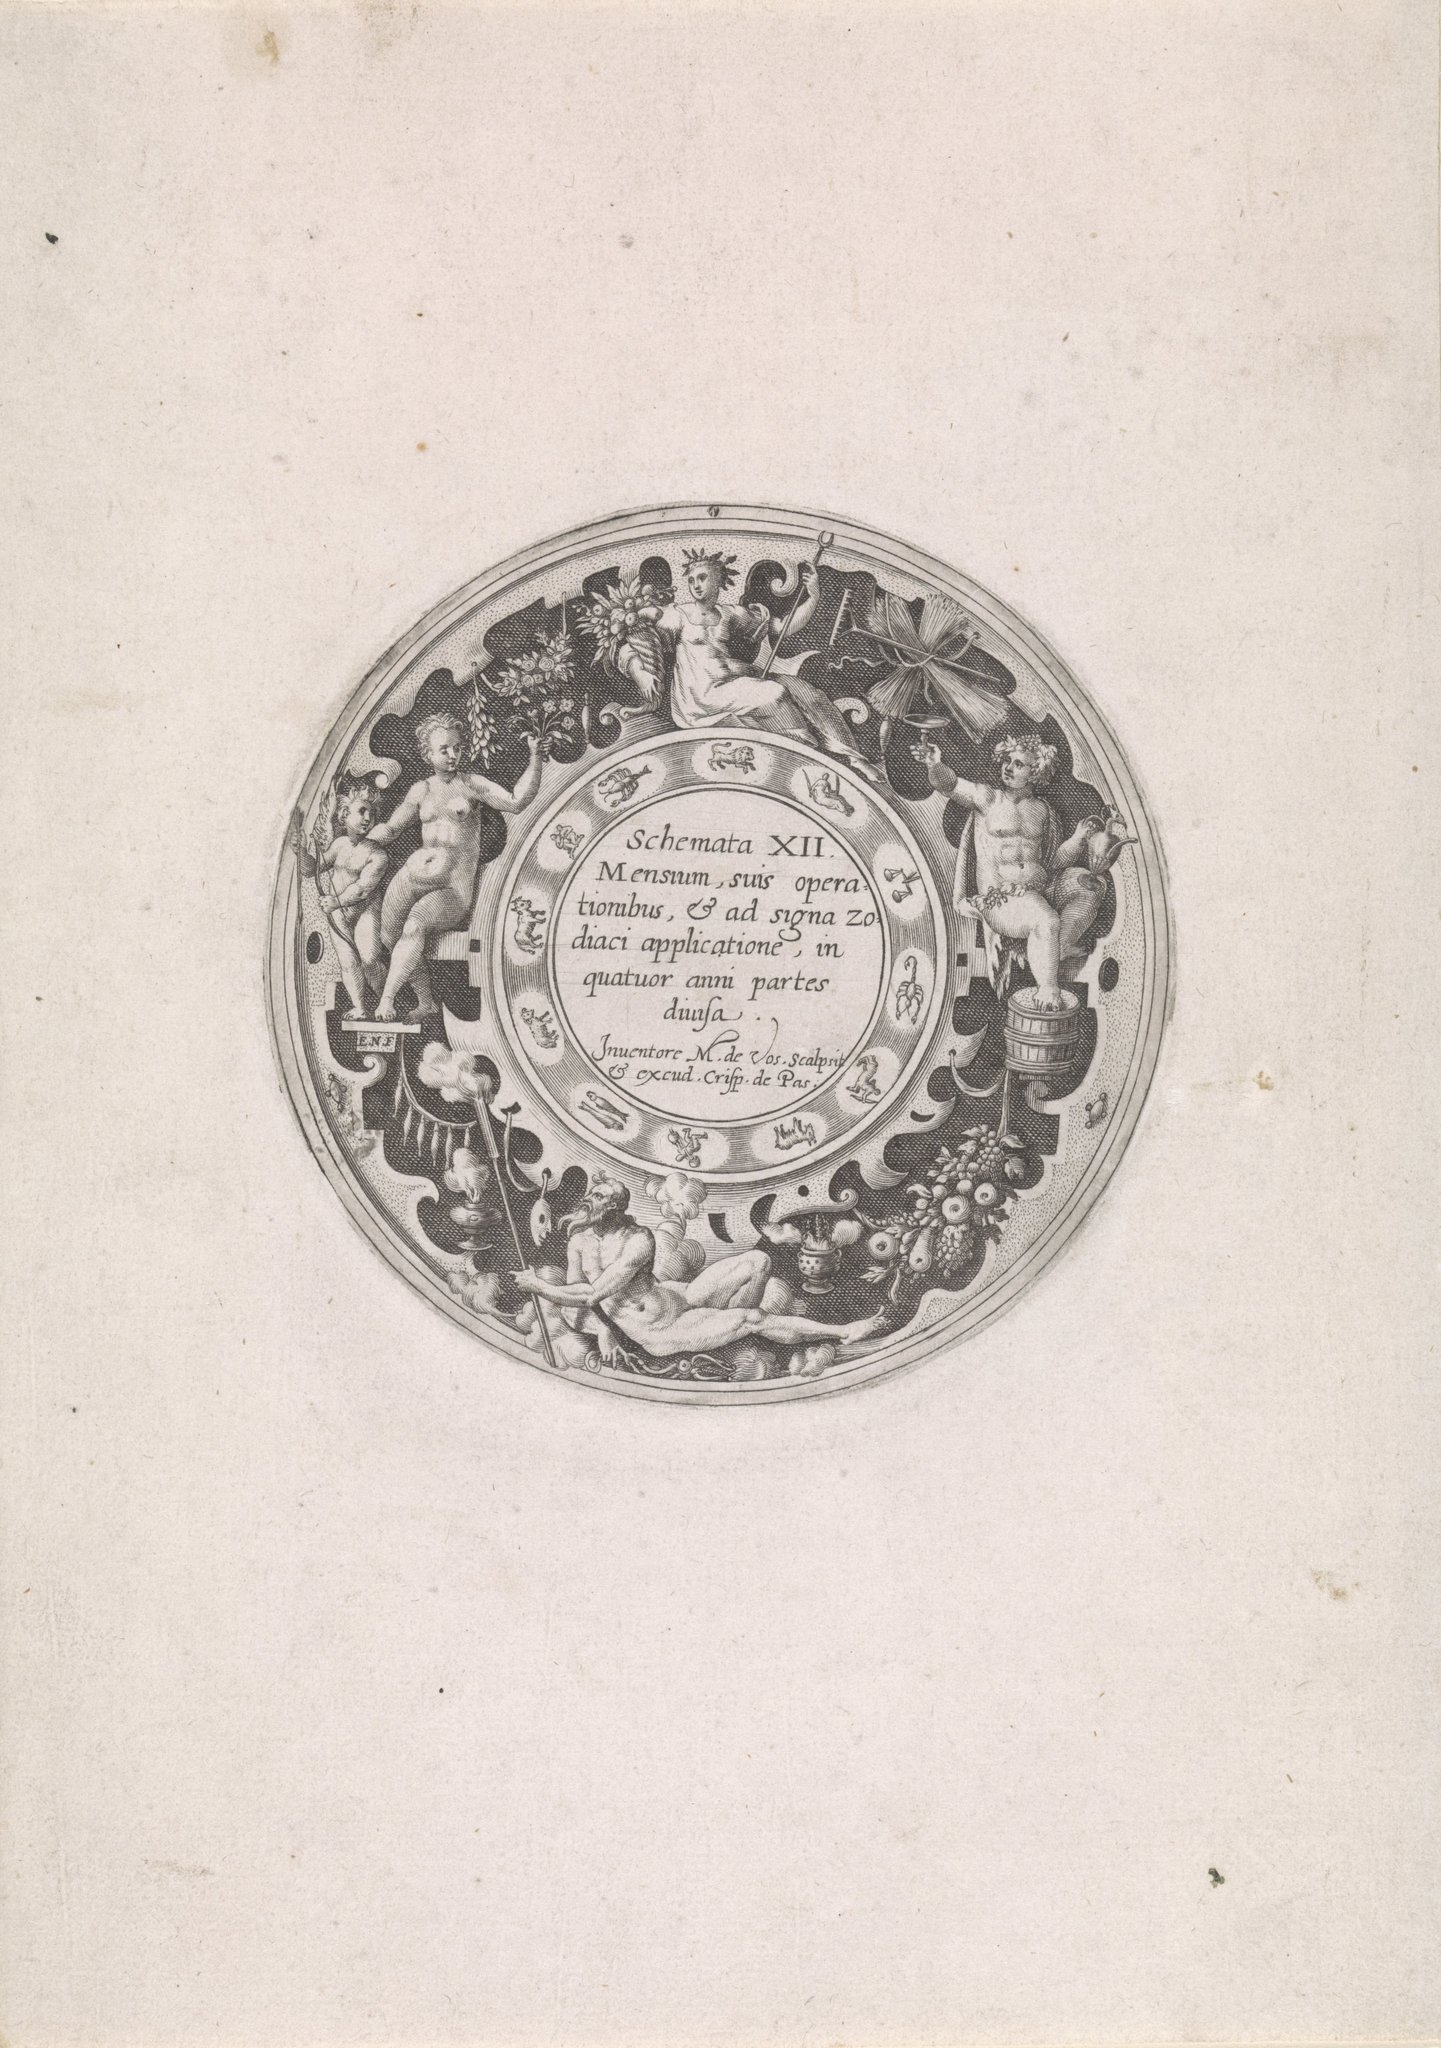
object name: titelprent, frontispice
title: Schemata XII. Mensium (...)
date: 1580-1588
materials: paper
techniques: engraving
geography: antwerp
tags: (story of) ceres (demeter), north wind, 'aquilo', 'boreas', 'septentrionarius' (one of eight directions), year divided into four seasons (+ ways of representing seasons and months), (story of) bacchus (dionysus), liber, (story of) venus (aphrodite), zodiac; the twelve zodiacal signs together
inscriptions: collector's mark: Lugt 2228, collector's mark: Lugt 2760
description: Medaillon met de serietitel in het Latijn en een ring met de twaalf tekens van de dierenriem. De prent heeft een omlijsting waarin Ceres, Bacchus, Boreas en Venus met Amor die de vier jaargetijden symboliseren.